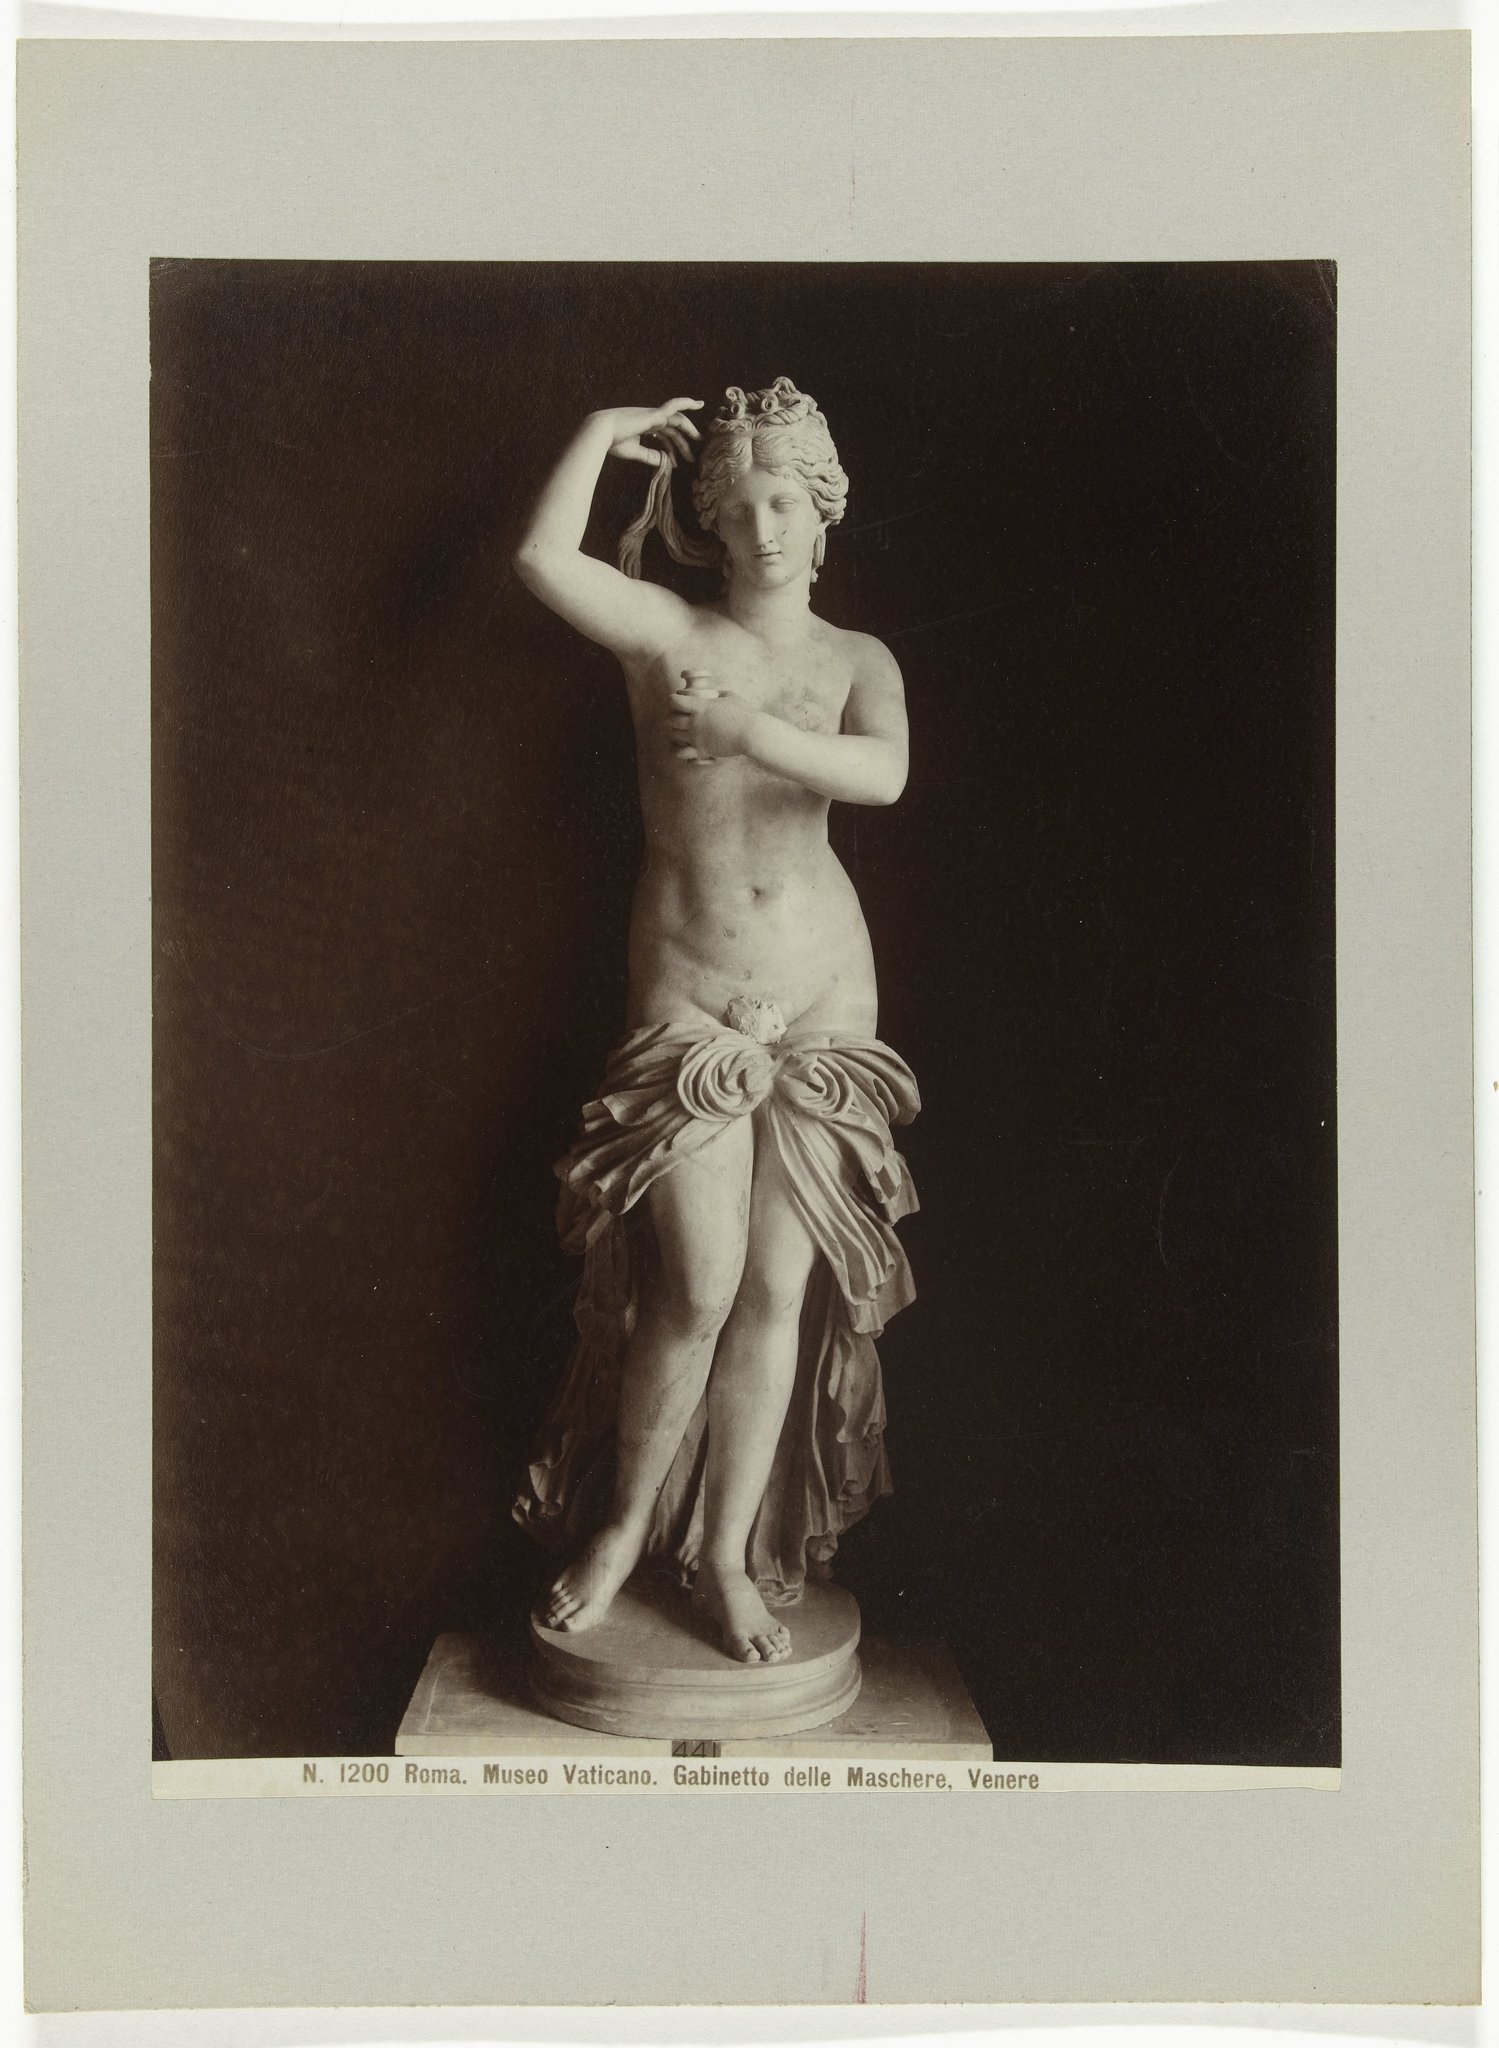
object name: photograph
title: N. 1200 Roma. Museo Vaticano. Gabinetto delle Maschere, Venere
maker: Anonymous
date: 1880-1904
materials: cardboard, paper, photographic support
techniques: albumen print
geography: rome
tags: vaticaanse musea